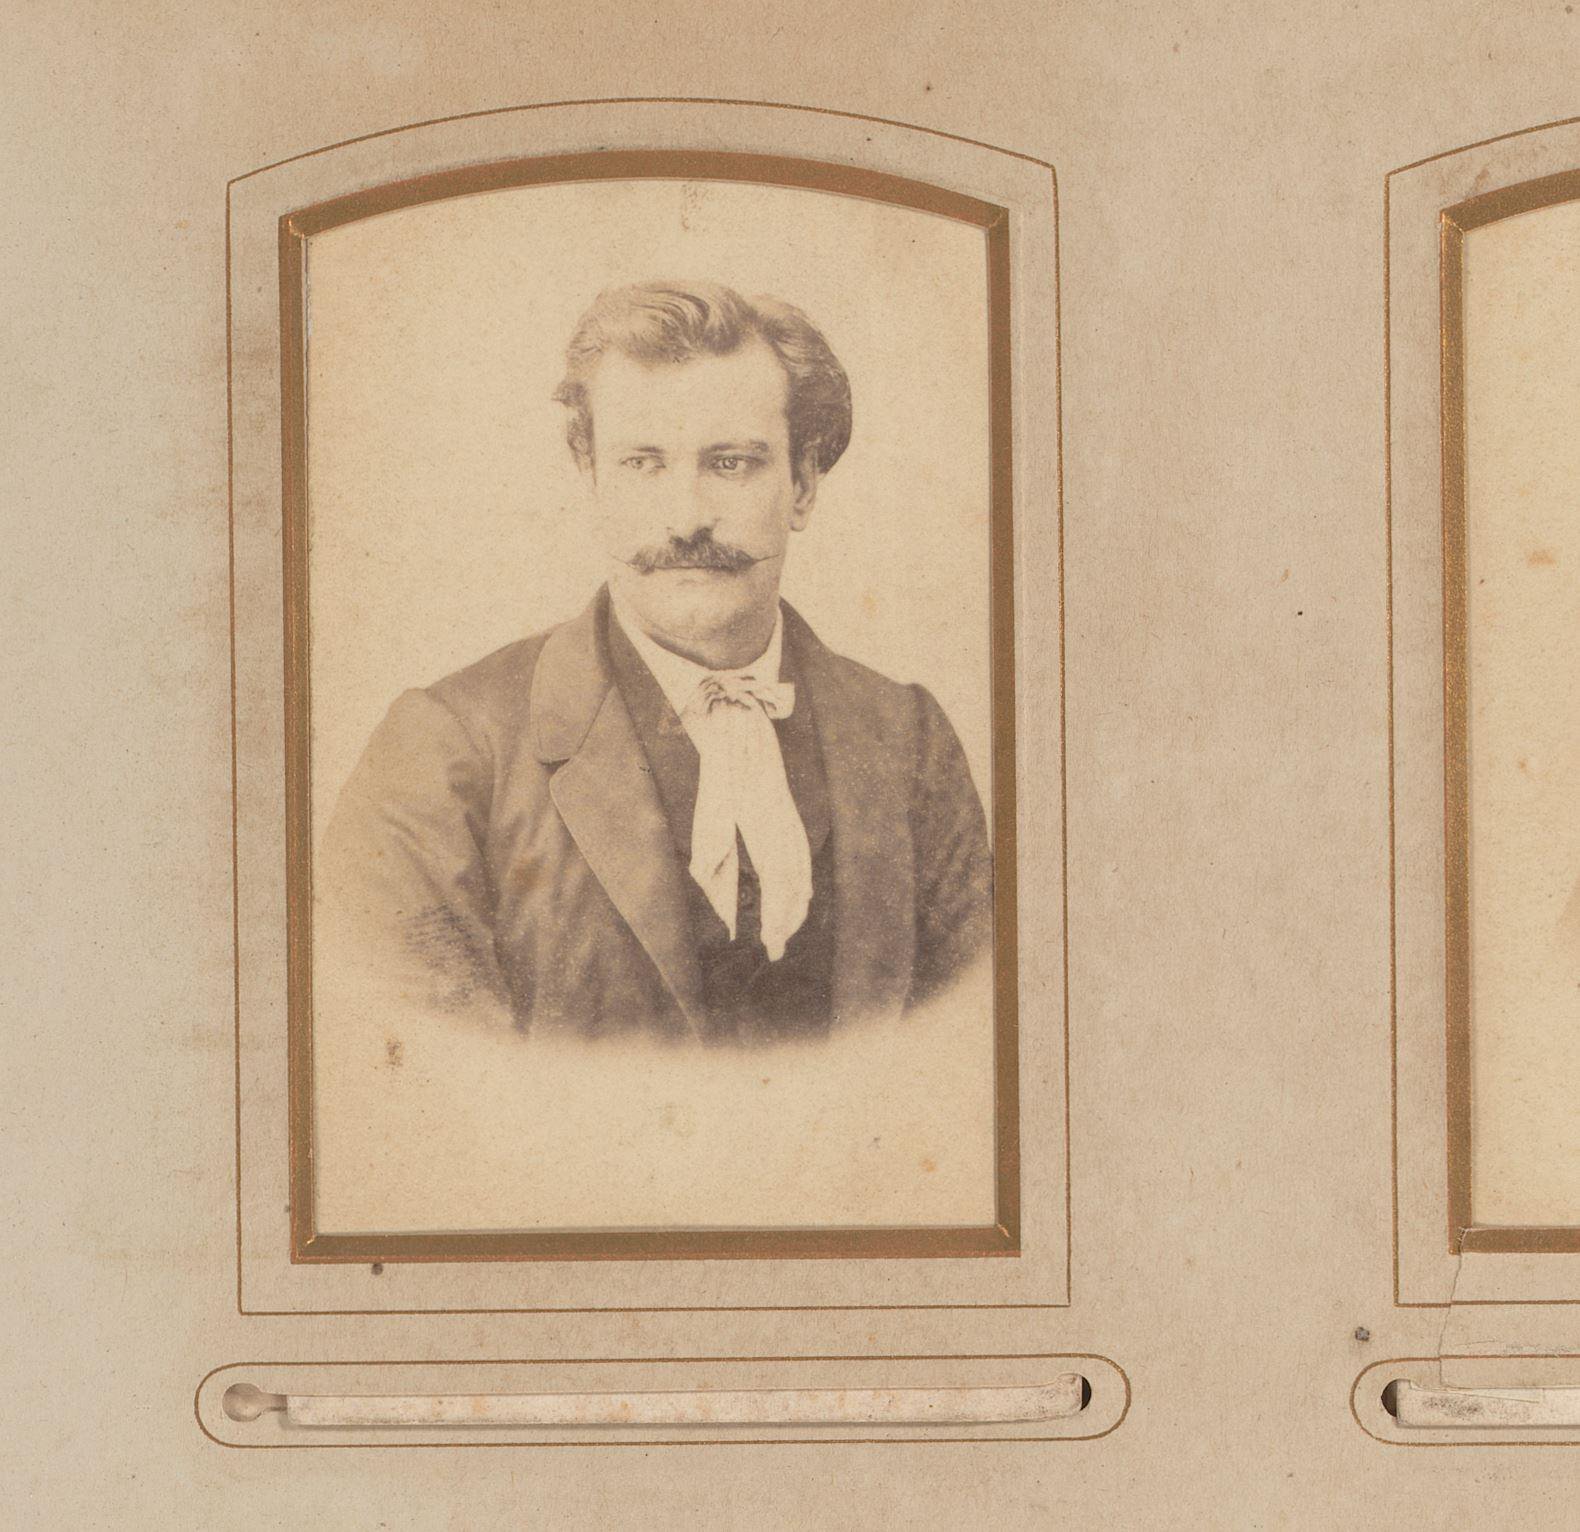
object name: photograph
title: Portret van een man met snor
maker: a. blavet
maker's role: fotograaf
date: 1870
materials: cardboard, photographic support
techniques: albumen print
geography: paris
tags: moustache, historical persons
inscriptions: inscription: ‘Grande Photographie/ PARISIENNE/ A. Blavet/ PHOTOGRAPHE.’